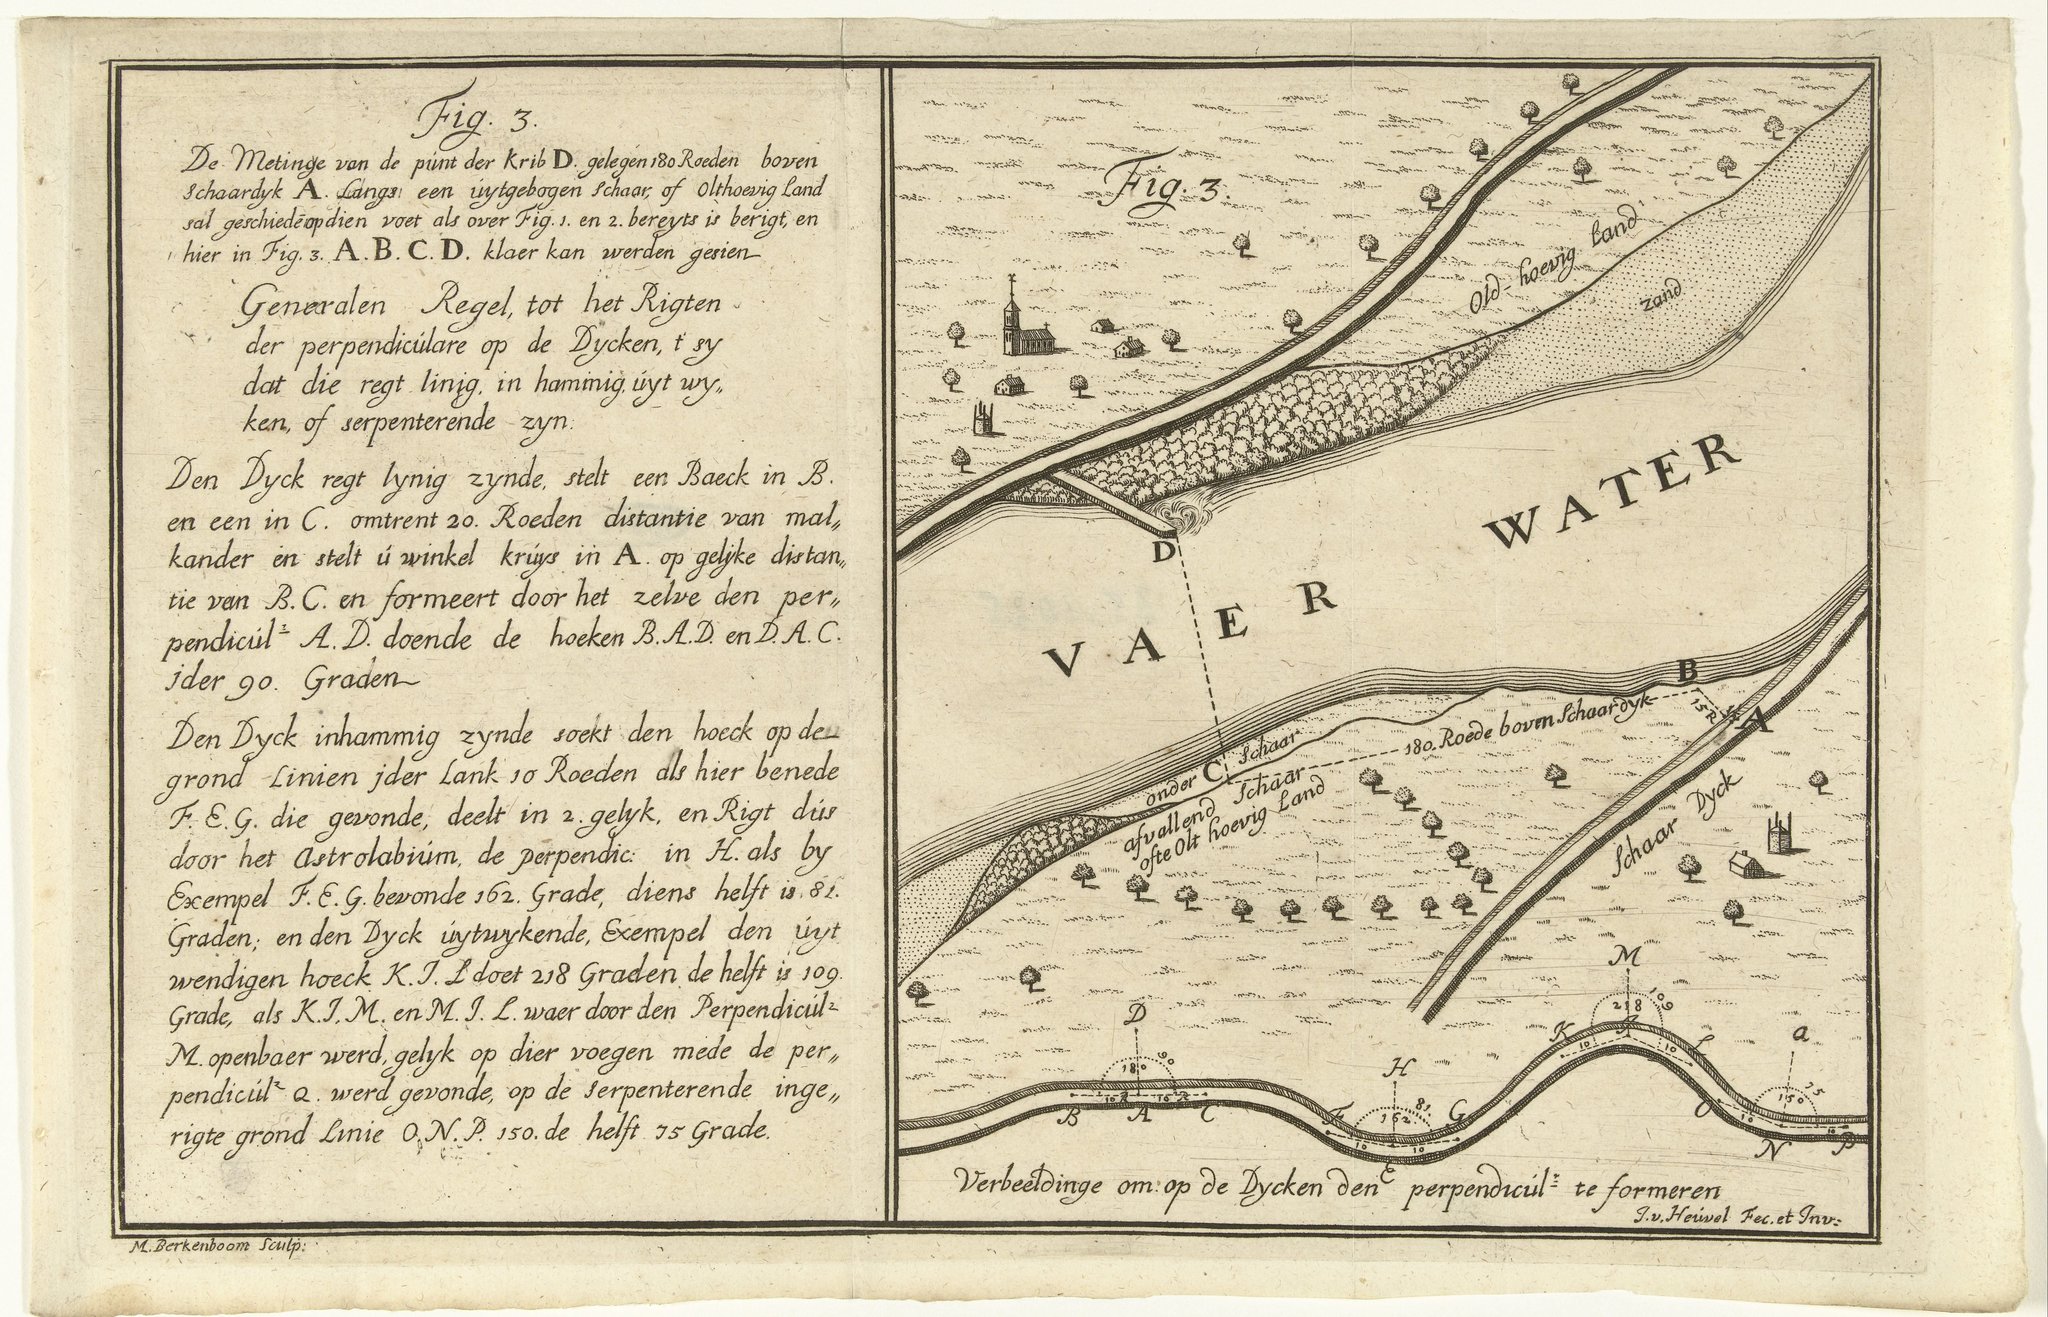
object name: print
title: Plattegrond van een stuk rivier met schaardijk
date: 1650-1715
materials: paper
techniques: etching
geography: nijmegen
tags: swamps and polders, dikes, levee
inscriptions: collector's mark: Lugt 2228, collector's mark: Lugt 2760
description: Plattegrond van een stuk rivier met schaardijk. Links een legenda van A-D. Prent maakt deel uit van een serie prenten over waterbouwkunde en inpoldering.